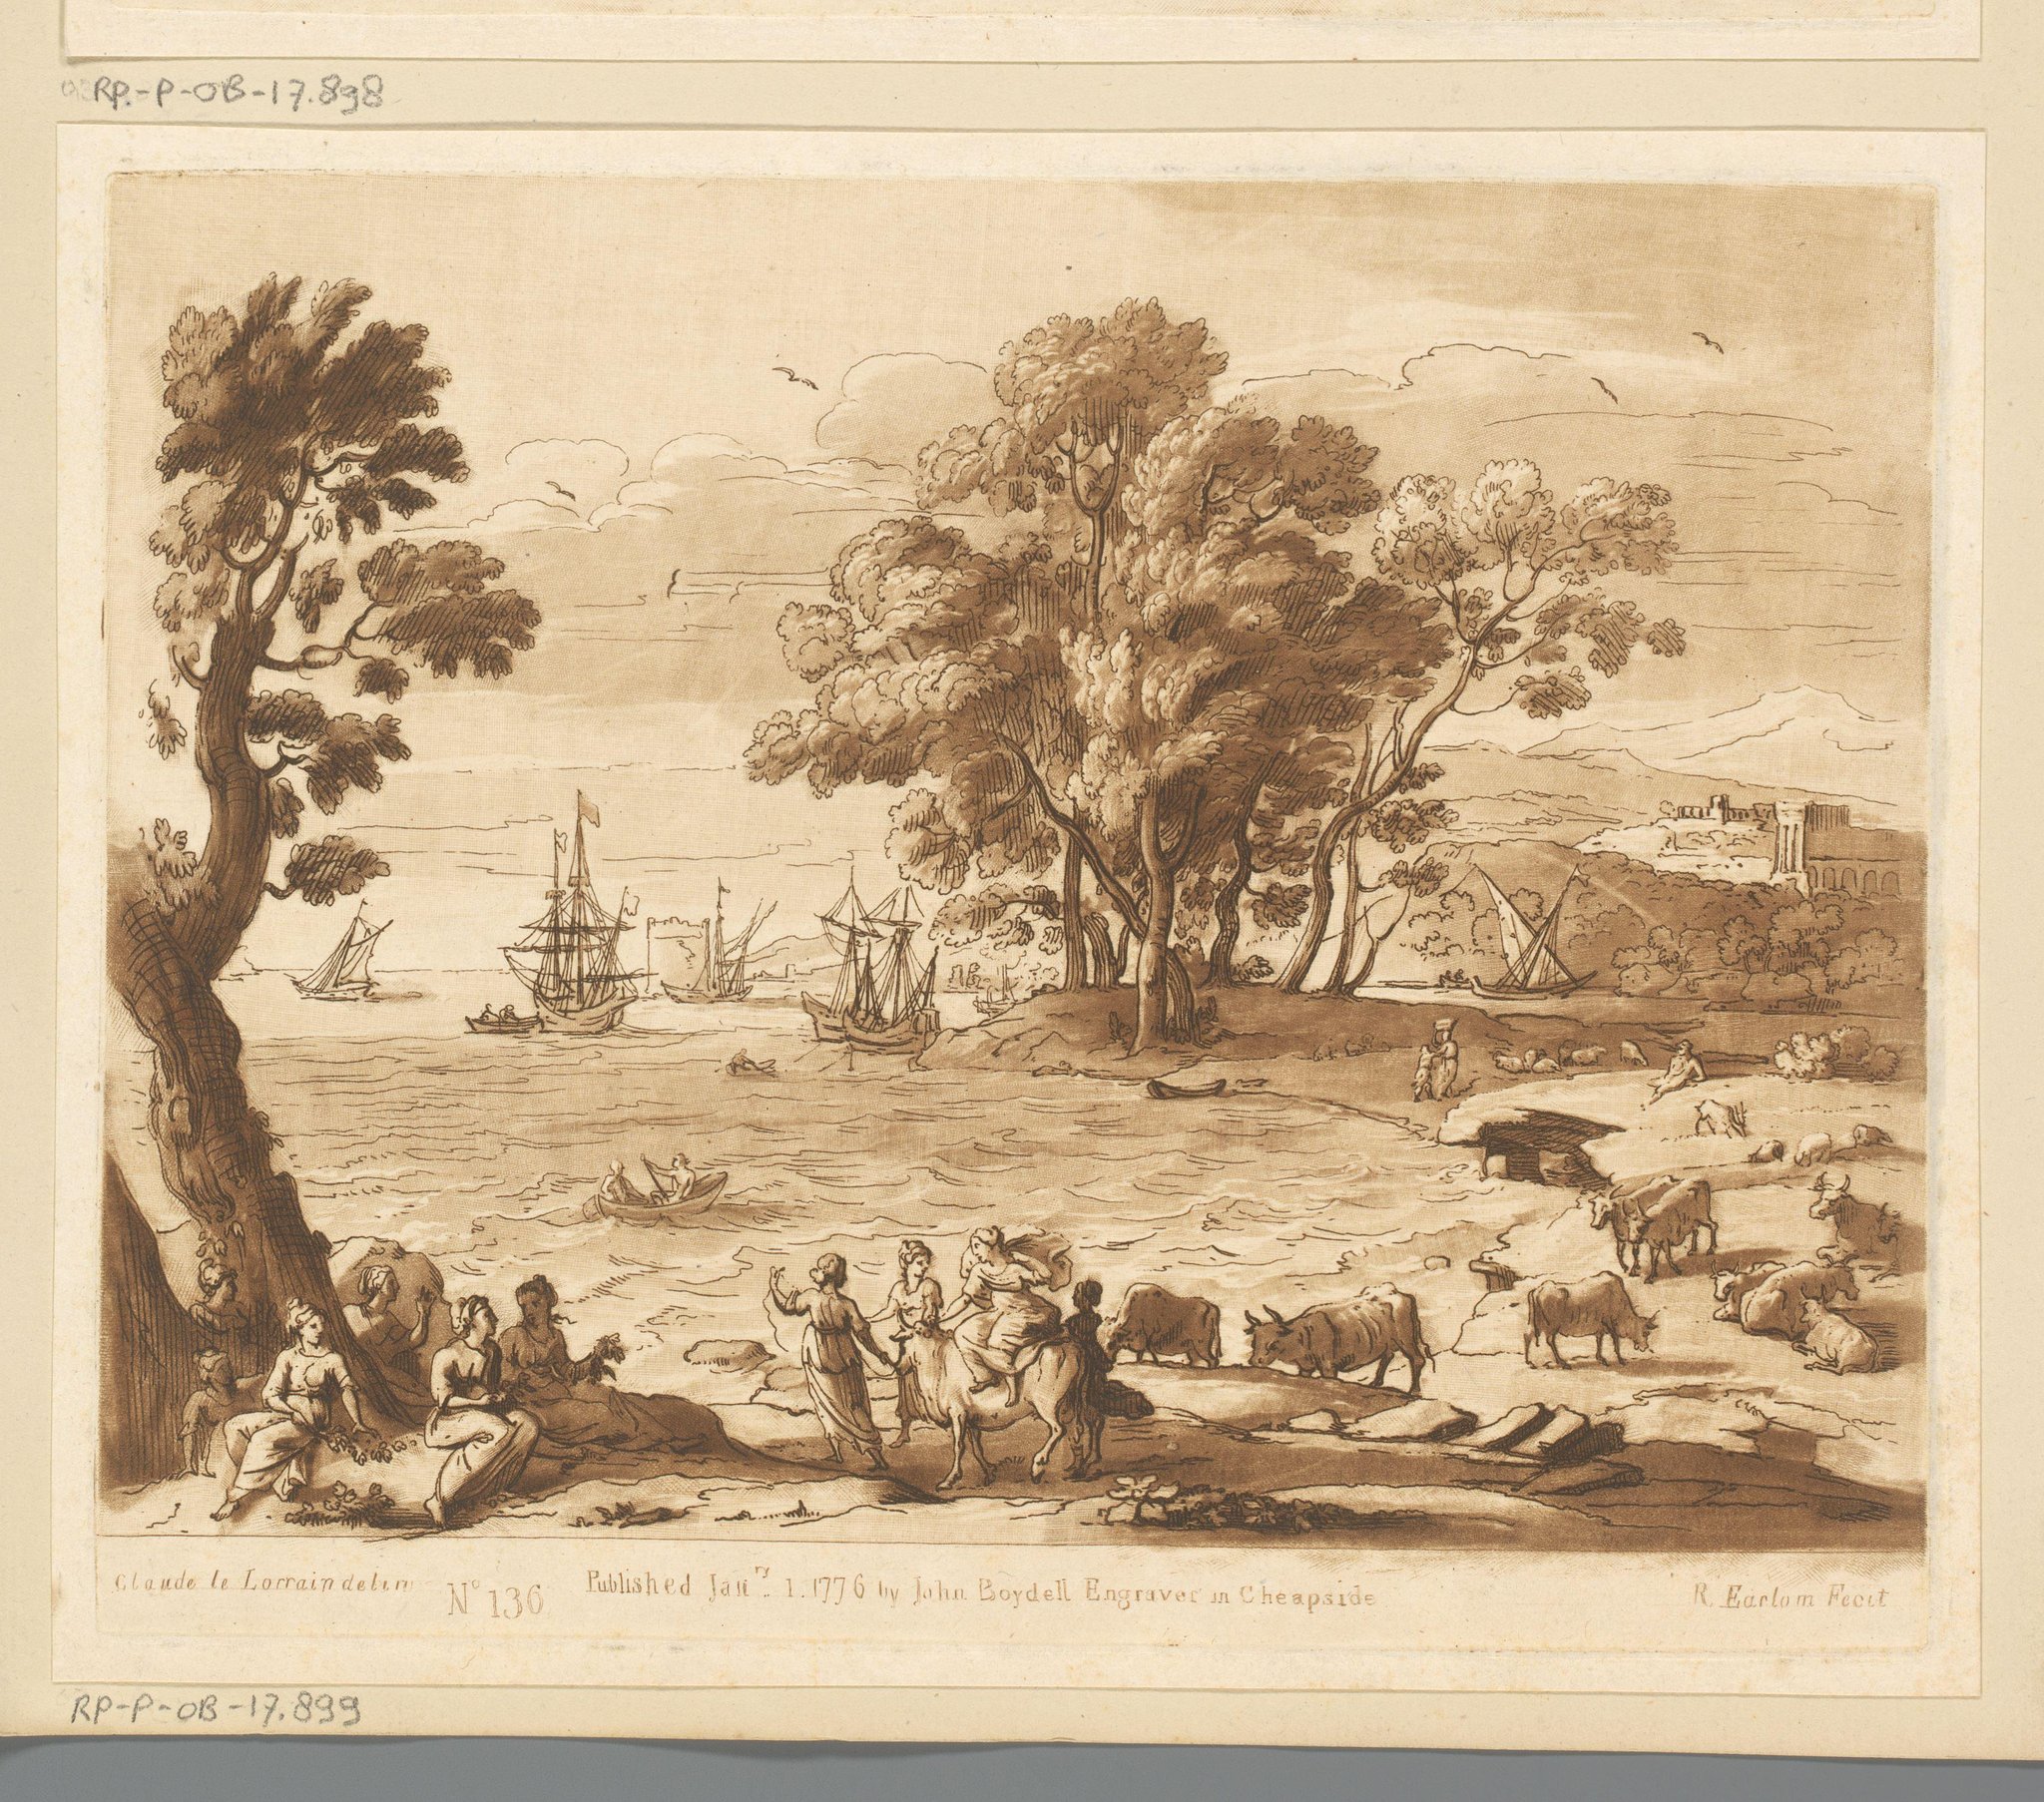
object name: print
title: Prenten naar tekeningen van Claude Lorrain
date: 1776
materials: paper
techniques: etching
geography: london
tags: sailing-ship, sailing-boat, coast - hh - ideal landscapes, sea (seascape), europa and her maidens play with the bull, and/or adorn it with flowers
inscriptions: date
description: Vanaf 1774 publiceerde John Boydell tweehonderd prenten naar het tekeningenboek Liber Veritatis van Claude Lorrain, in het bezit van de hertogen van Cavendish. Deze prenten werden vanaf 1777 in twee volumes gebundeld uitgegeven.